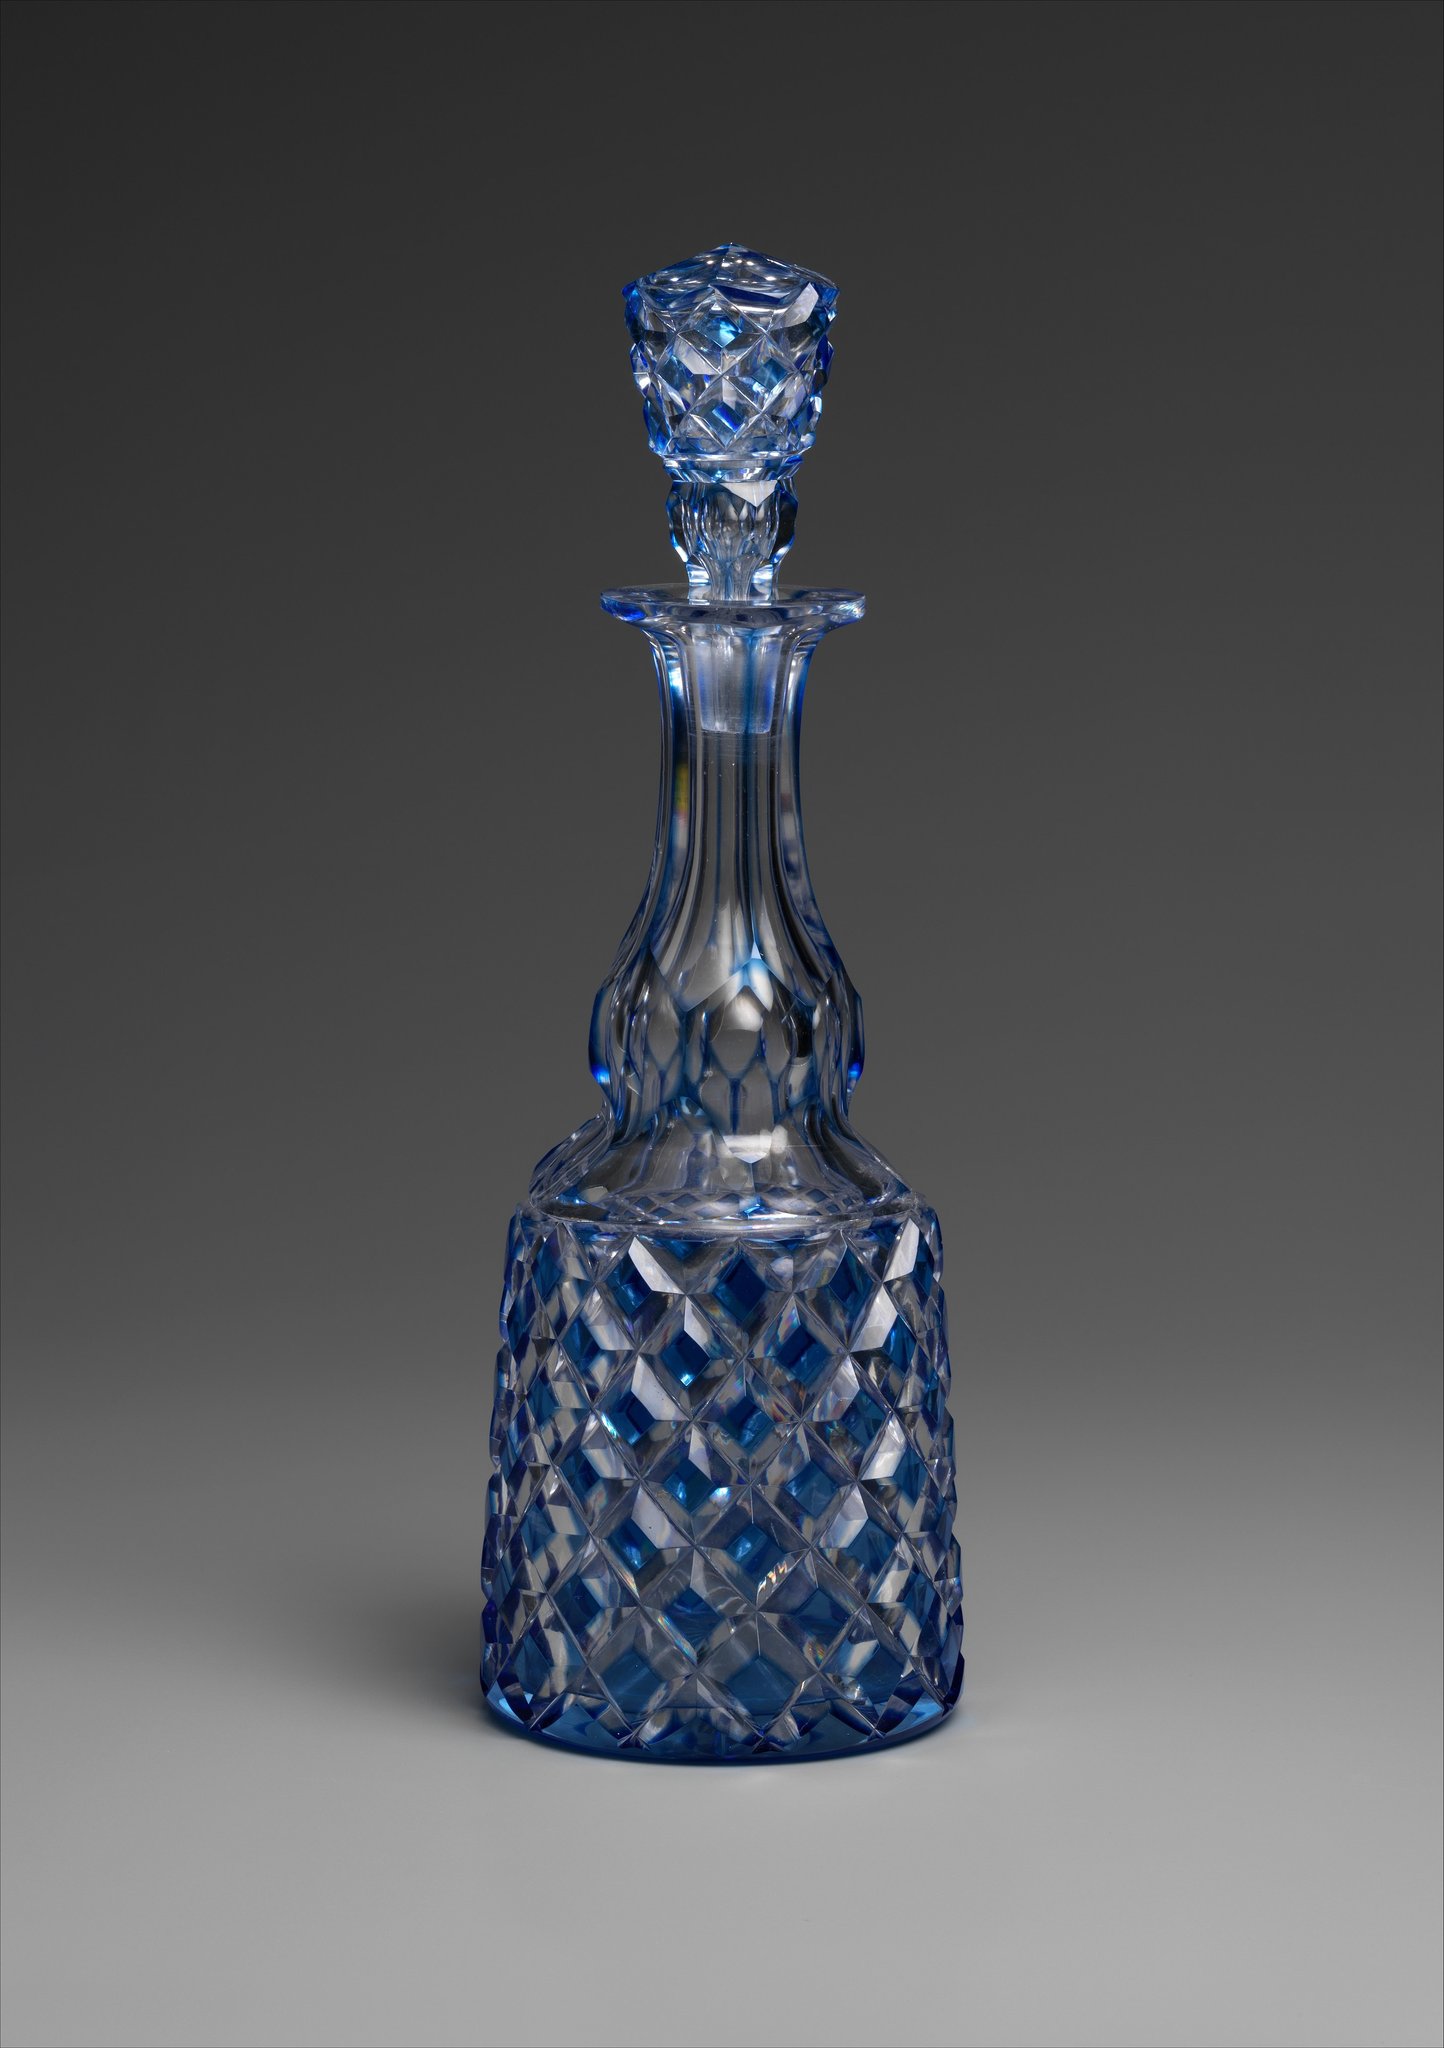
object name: decanter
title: Decanter with stopper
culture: american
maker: brooklyn flint glass company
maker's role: manufacturer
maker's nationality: american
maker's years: 1824-1868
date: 1850-1855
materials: glass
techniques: cutting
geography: united states